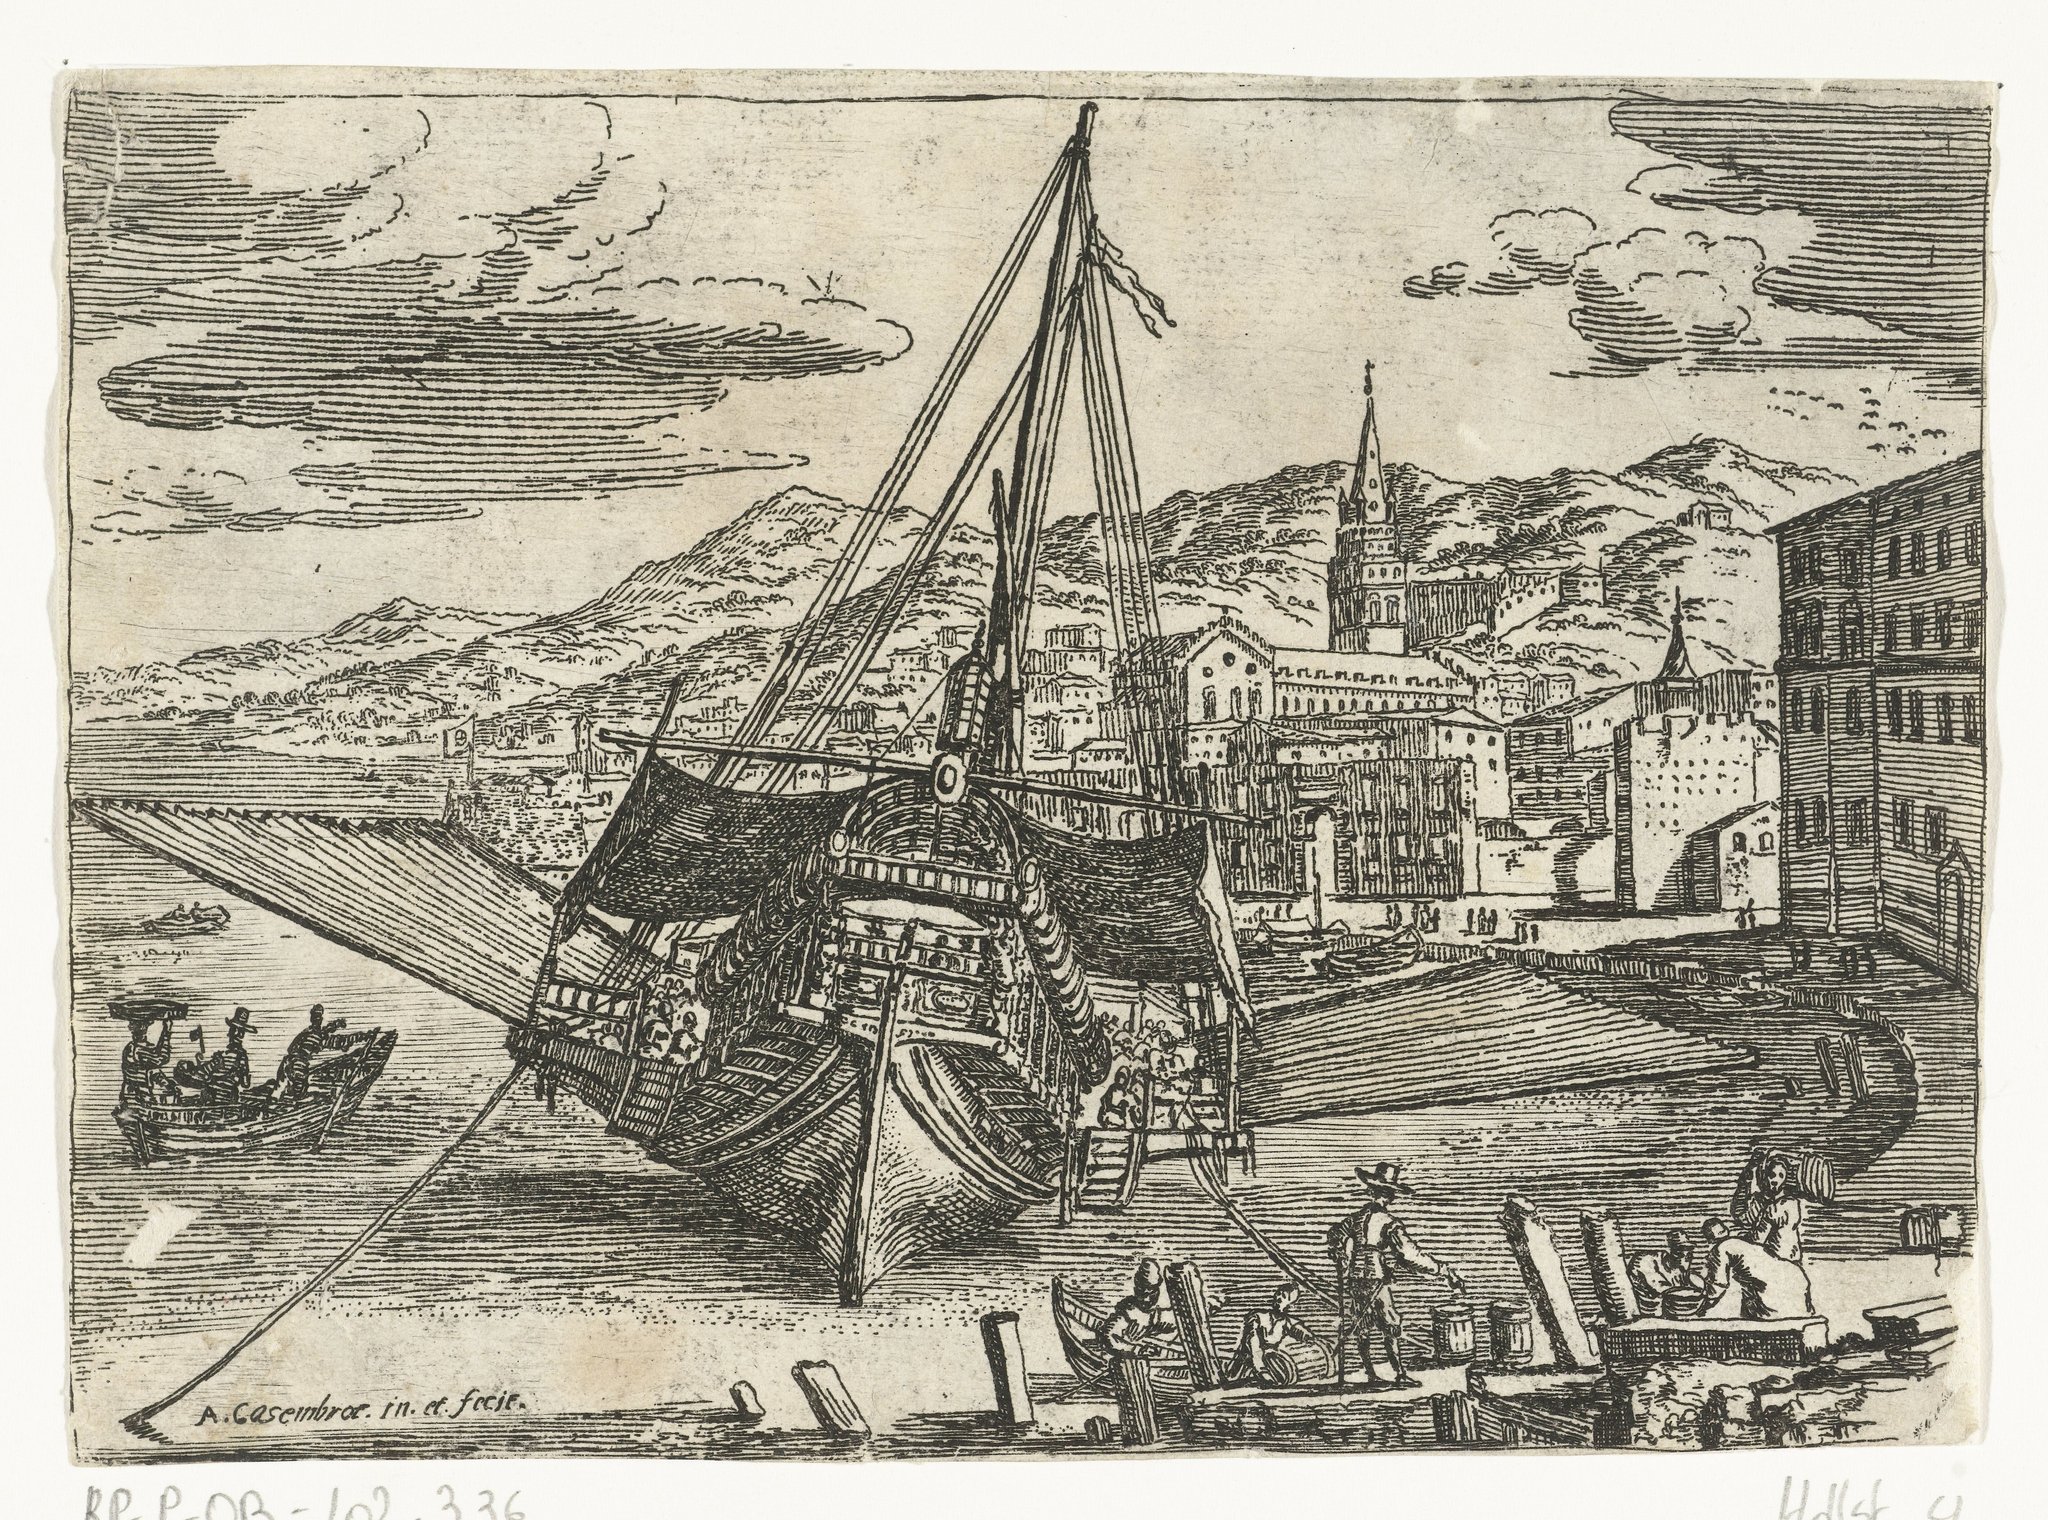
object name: print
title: Galei voor anker aan de kade van de haven van Messina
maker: abraham de casembroot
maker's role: draughtsman, print maker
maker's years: 1573-1658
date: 1603-1658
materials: paper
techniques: etching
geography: southern netherlands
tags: harbour, warfare; military affairs (+ oared ships, e.g.: galley), quay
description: Gezicht op een kade van de haven van Messina. Op de voorgrond ligt een galei voor anker. Een roeiboot met passagiers vaart naar het schip toe.